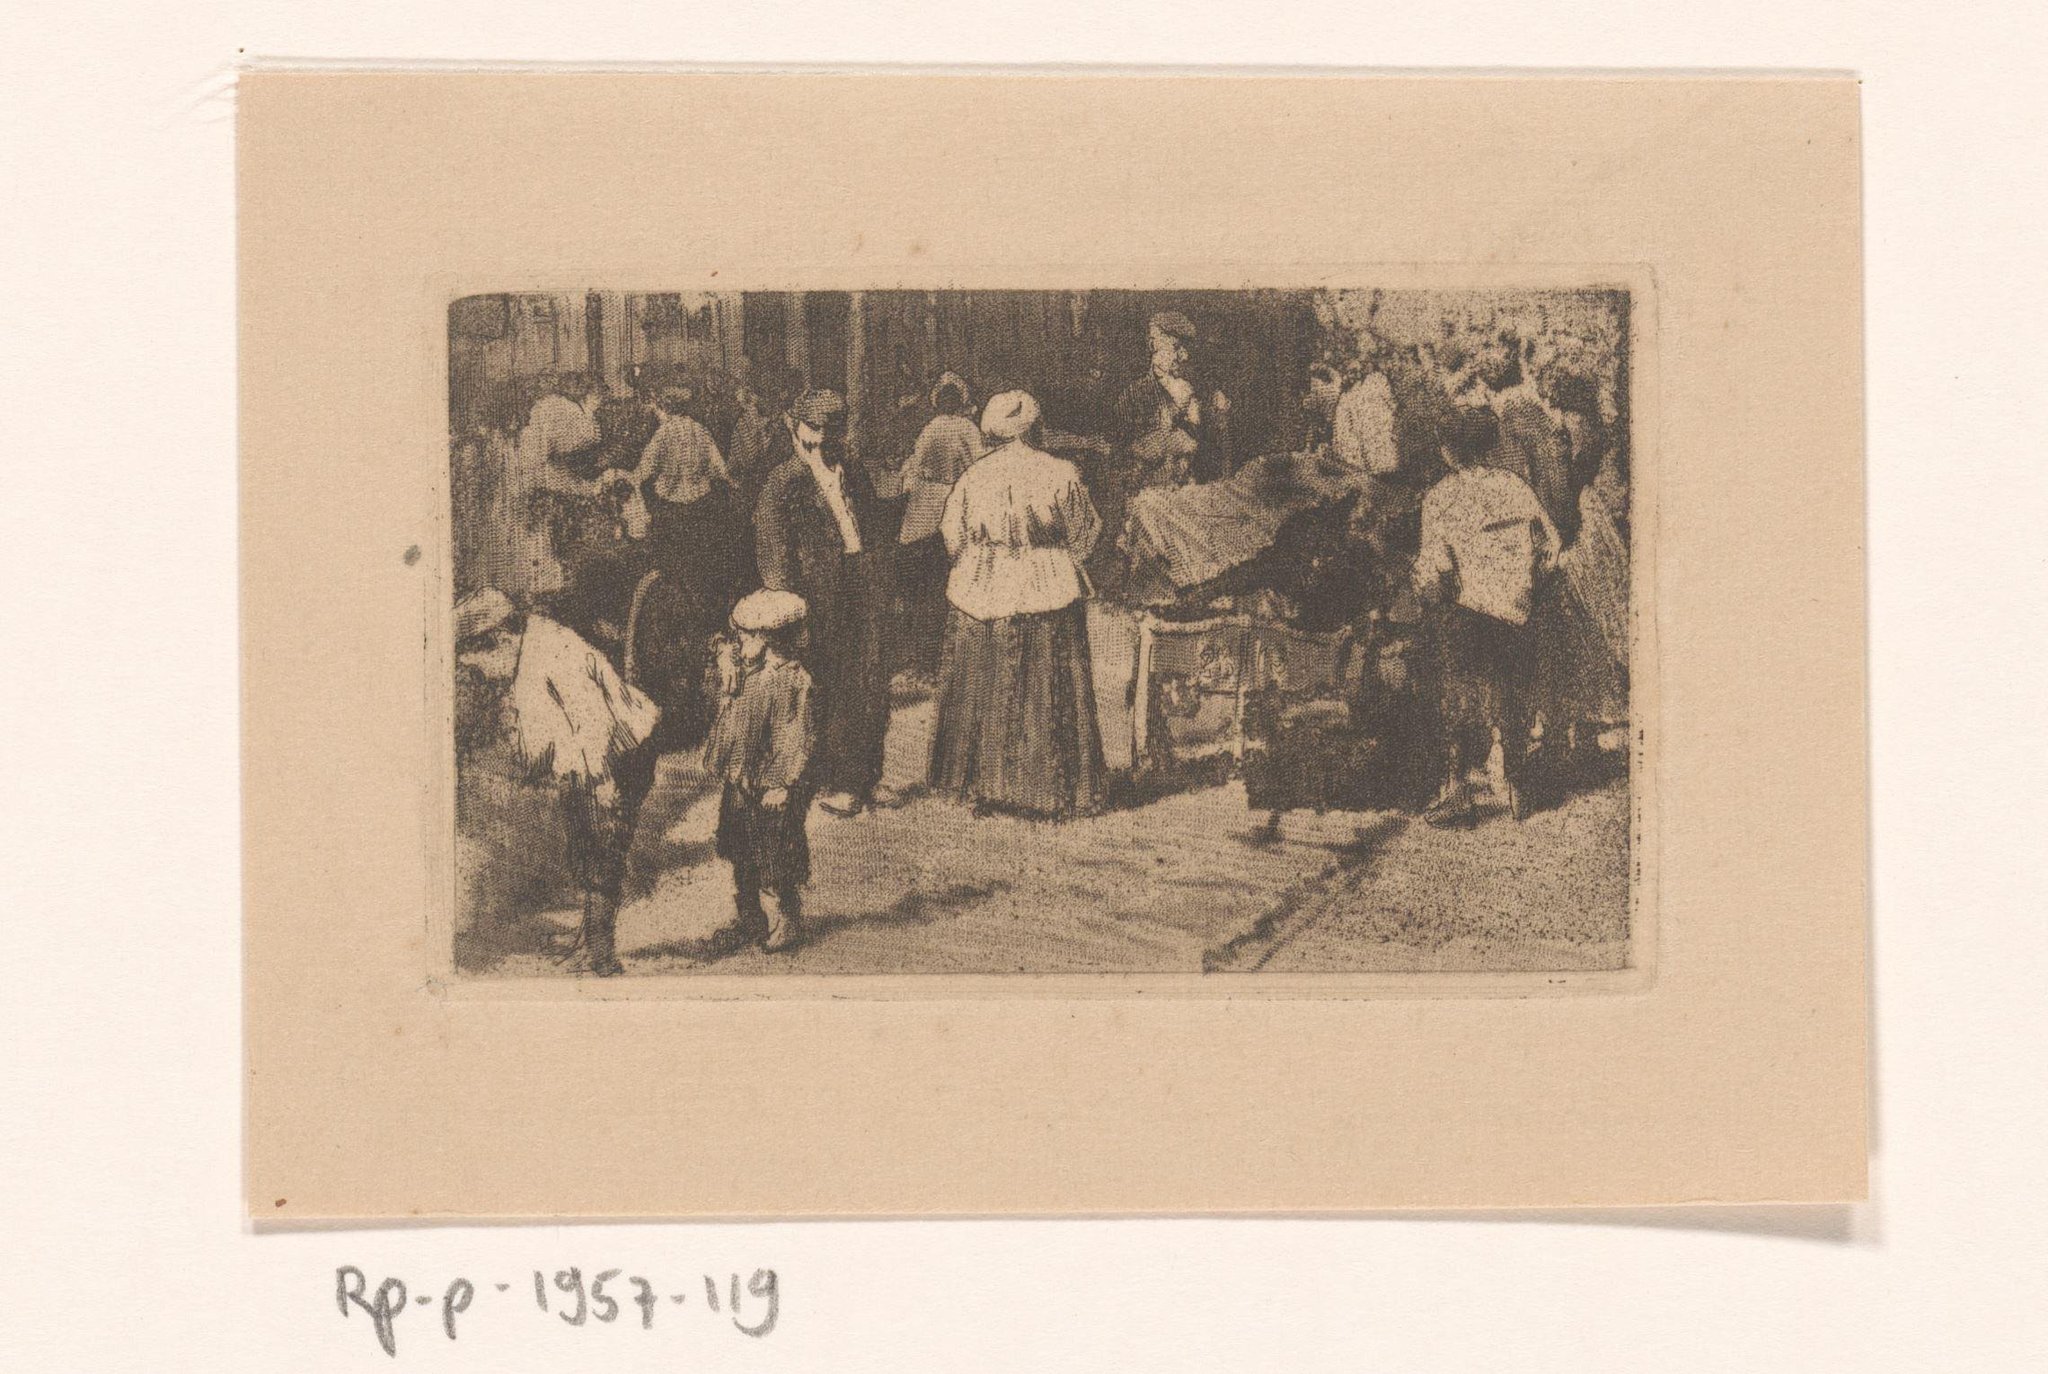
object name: print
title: Menigte op een markt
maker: chris van der windt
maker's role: print maker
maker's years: 1877-1952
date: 1887-1952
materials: paper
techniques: etching, roulette, soft ground etching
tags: market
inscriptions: collector's mark: Lugt 2228